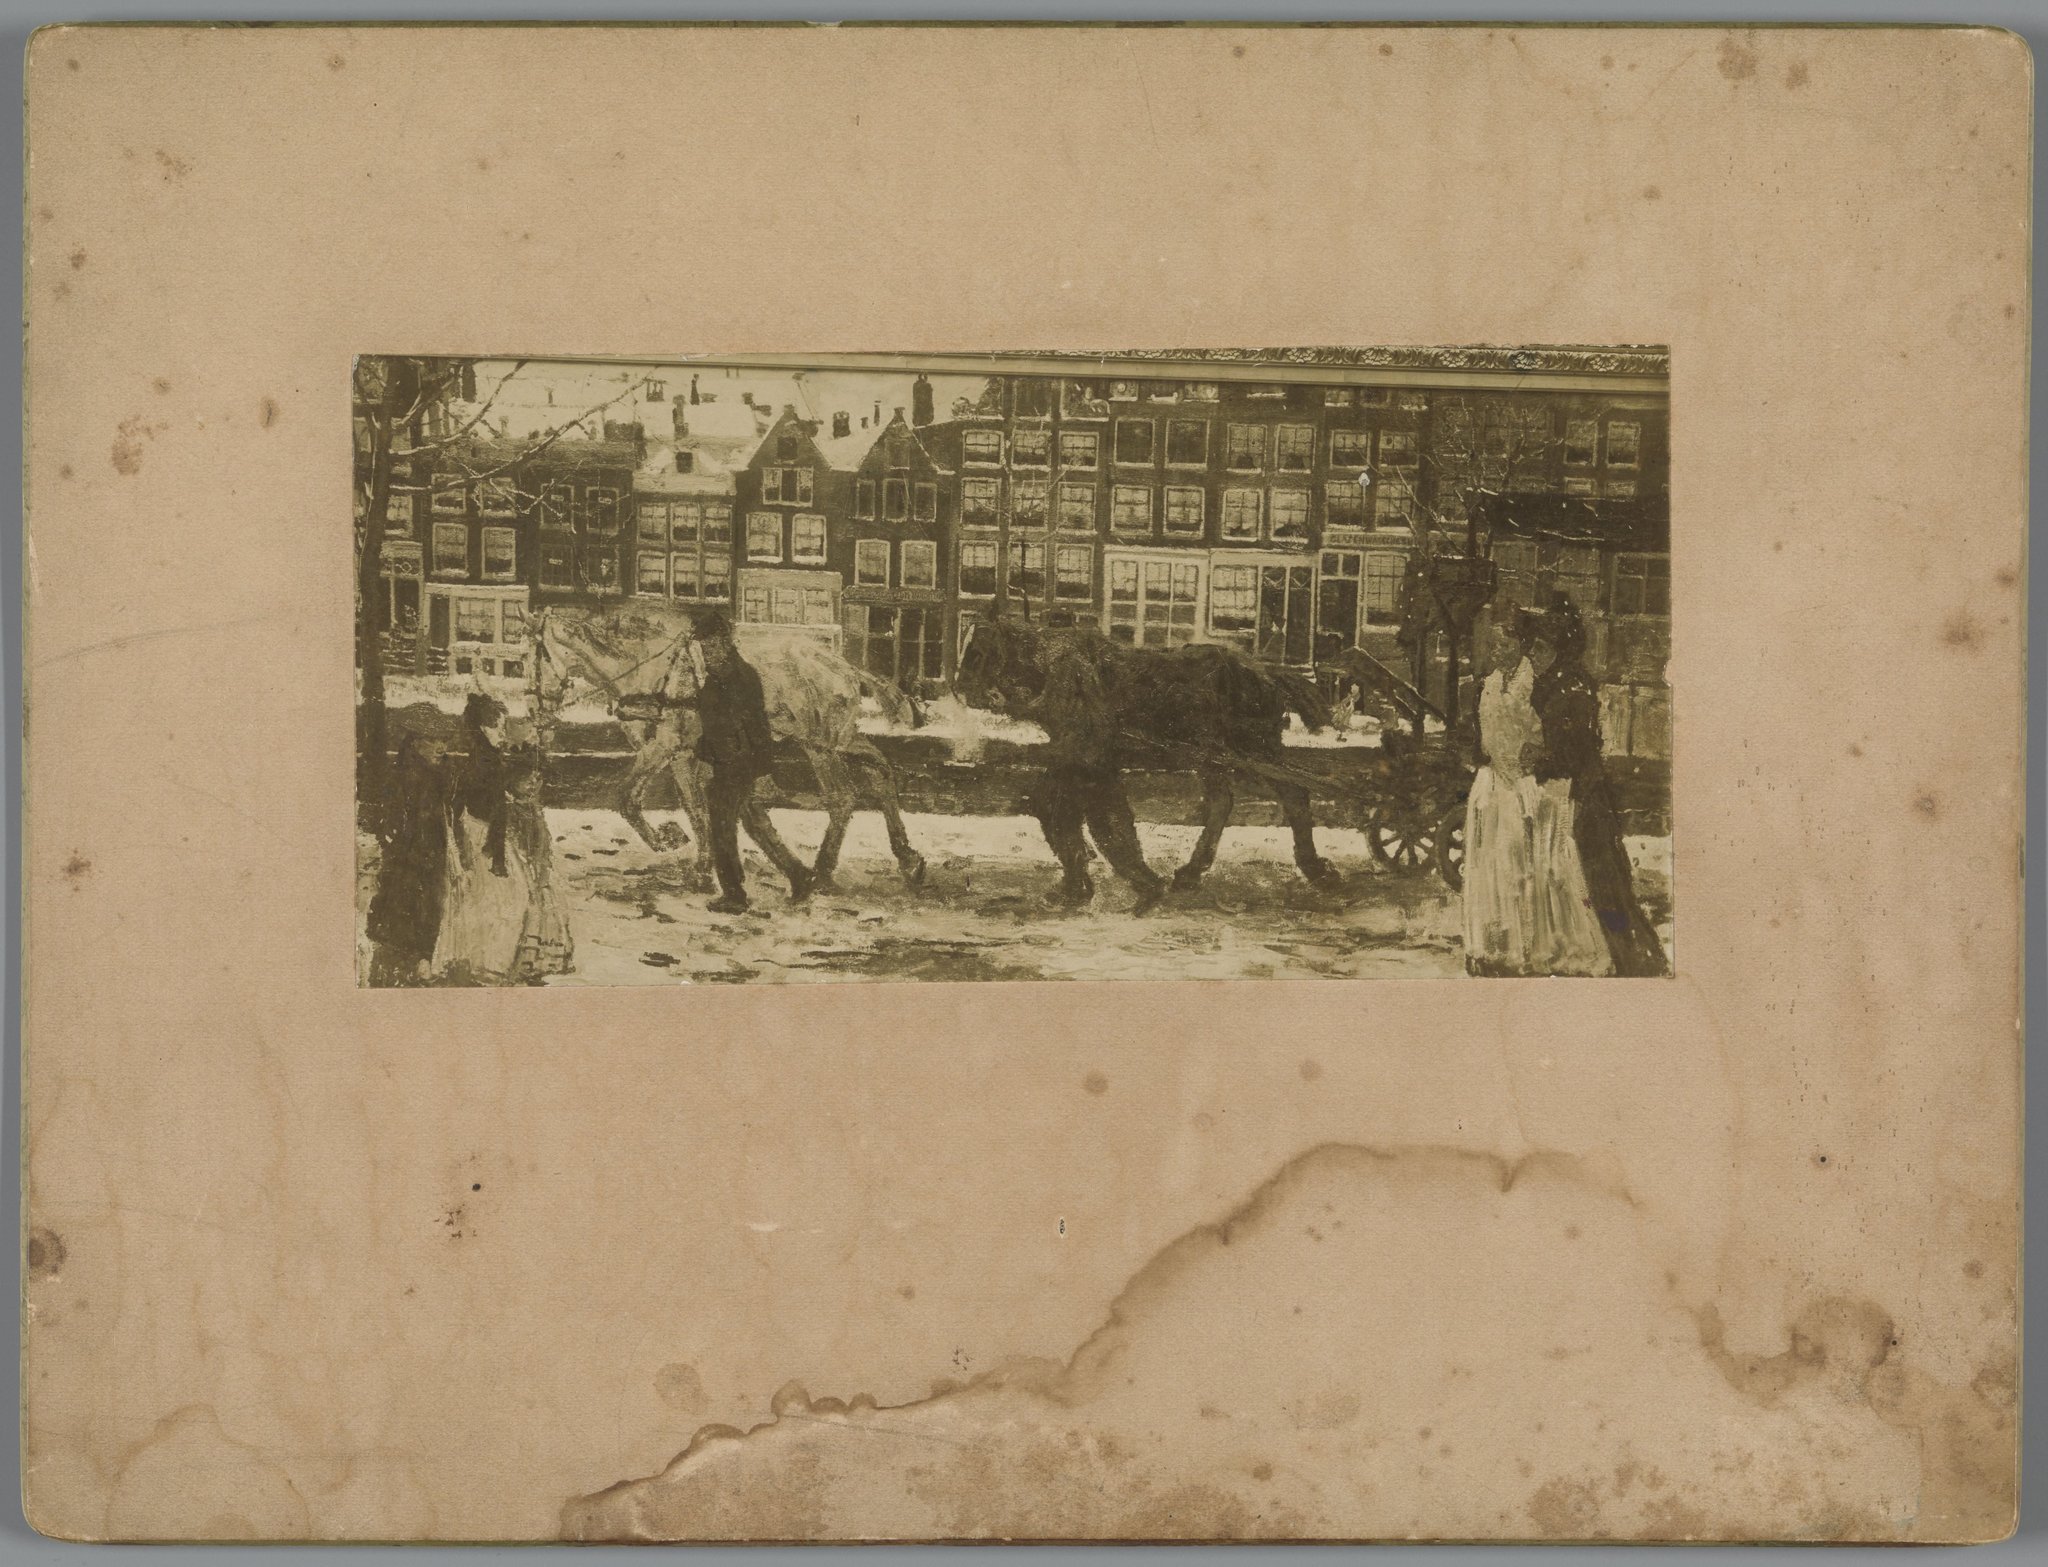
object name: photograph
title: Reproductie naar een foto, schilderij, tekening of prent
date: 1860-1915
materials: cardboard, paper, photographic support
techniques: gelatin silver print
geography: netherlands